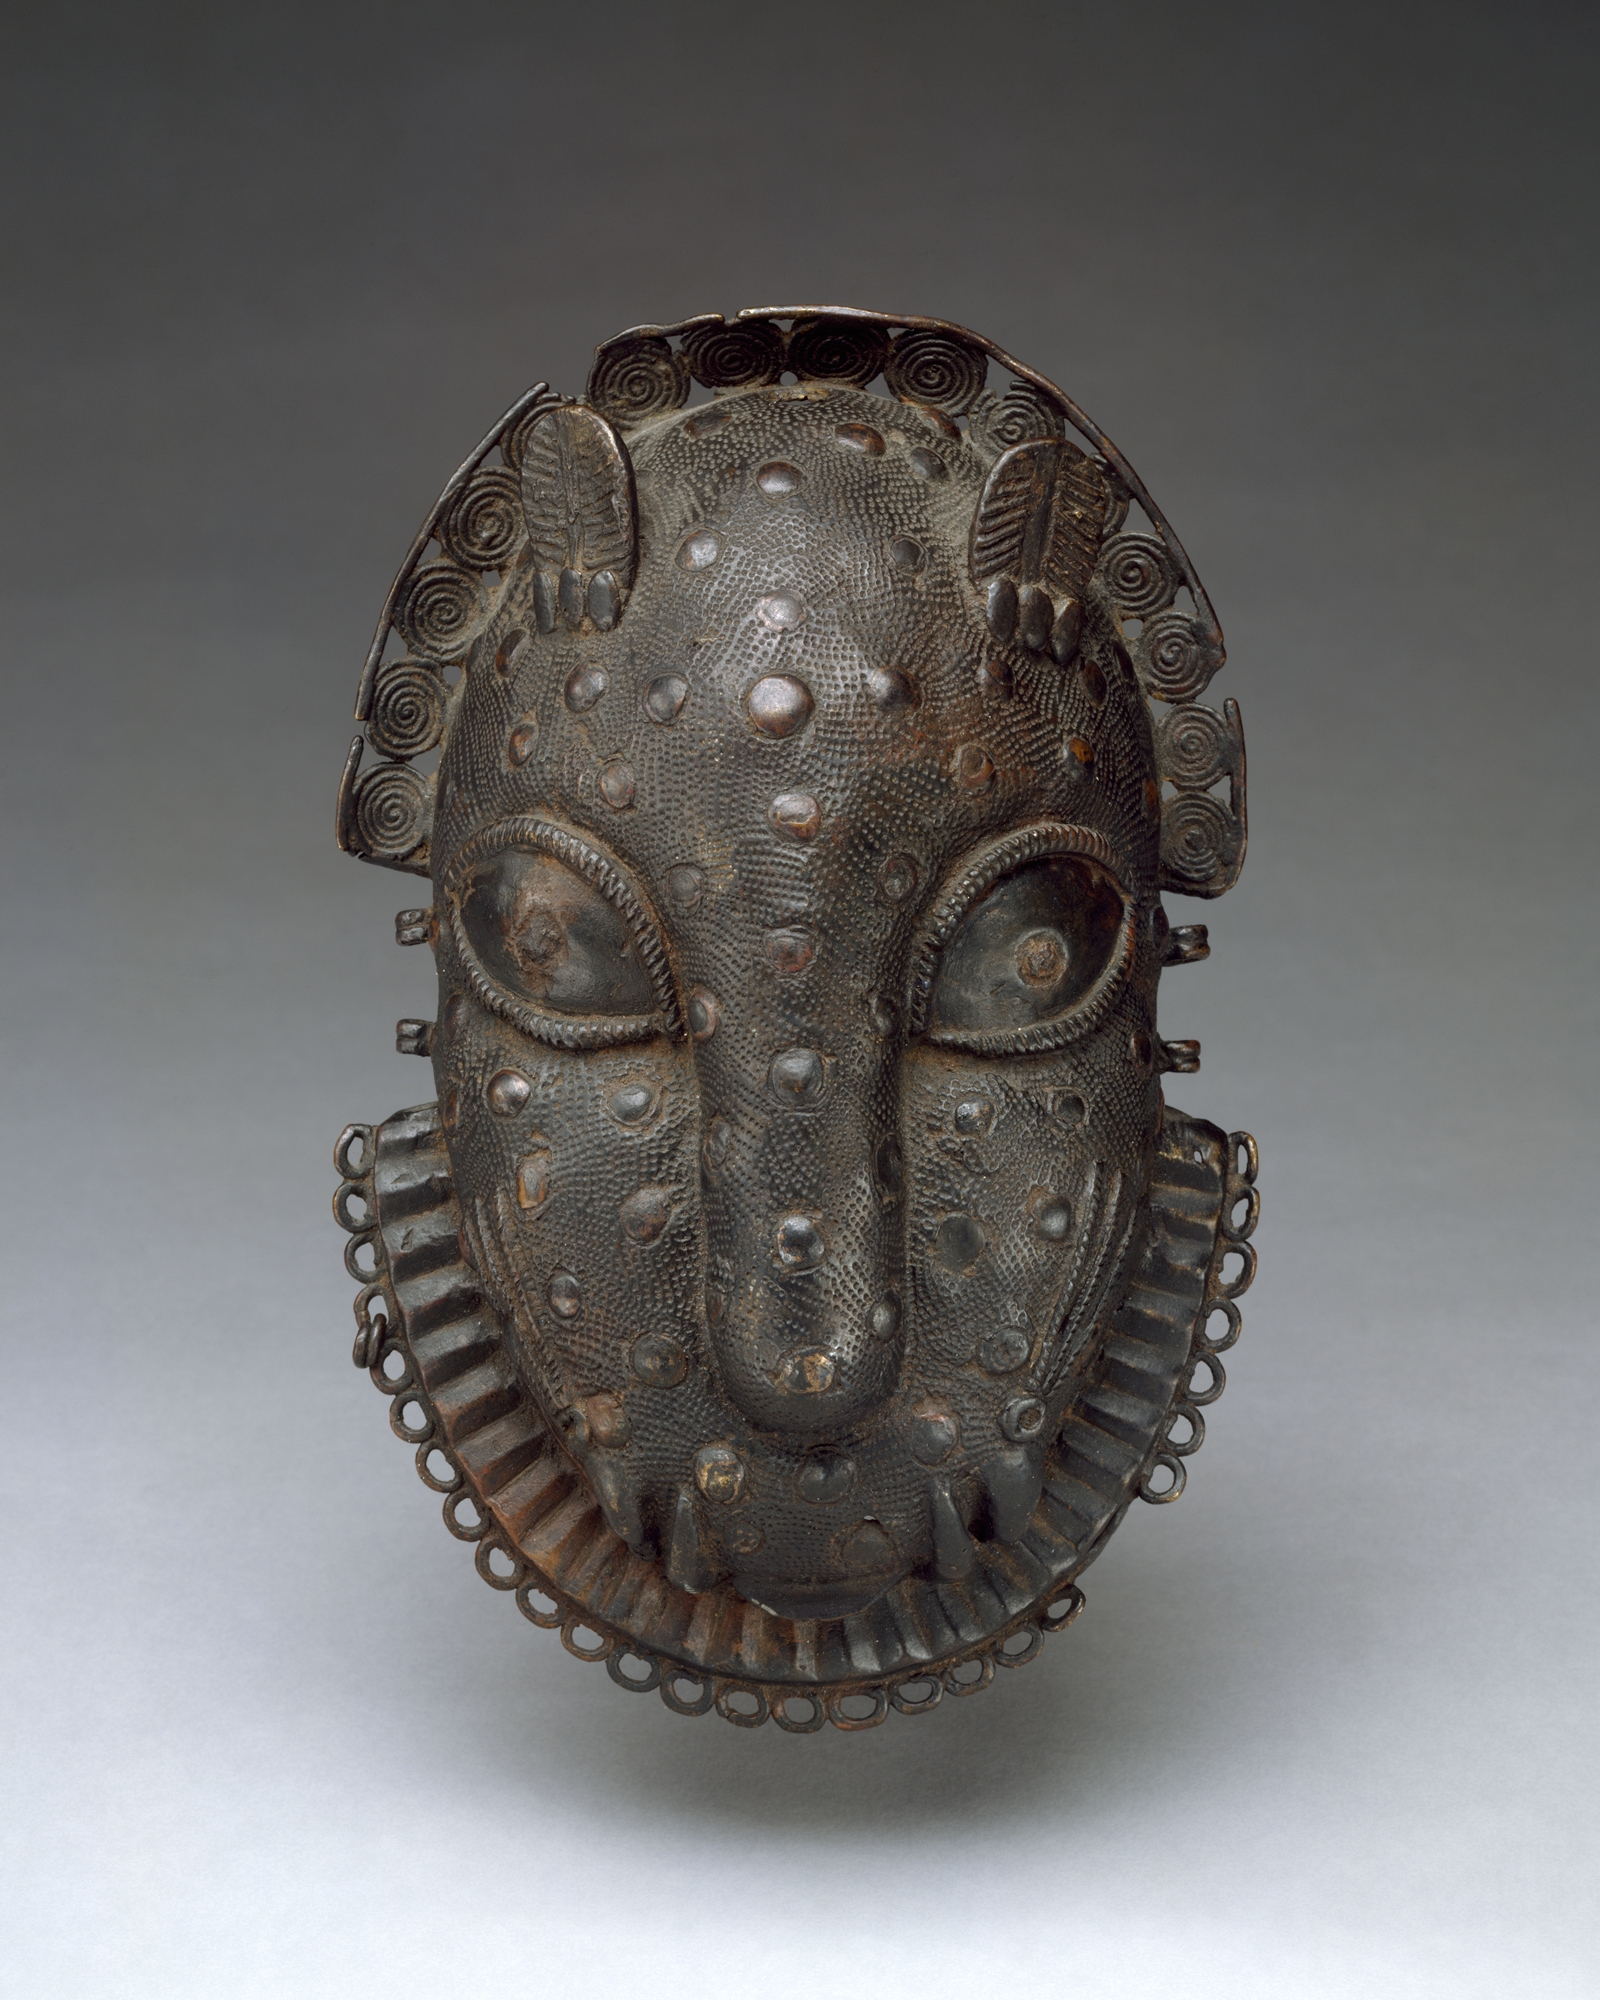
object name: ornament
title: Hip Ornament: Leopard Head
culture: edo period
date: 1501-1900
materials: brass, iron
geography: nigeria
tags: leopards